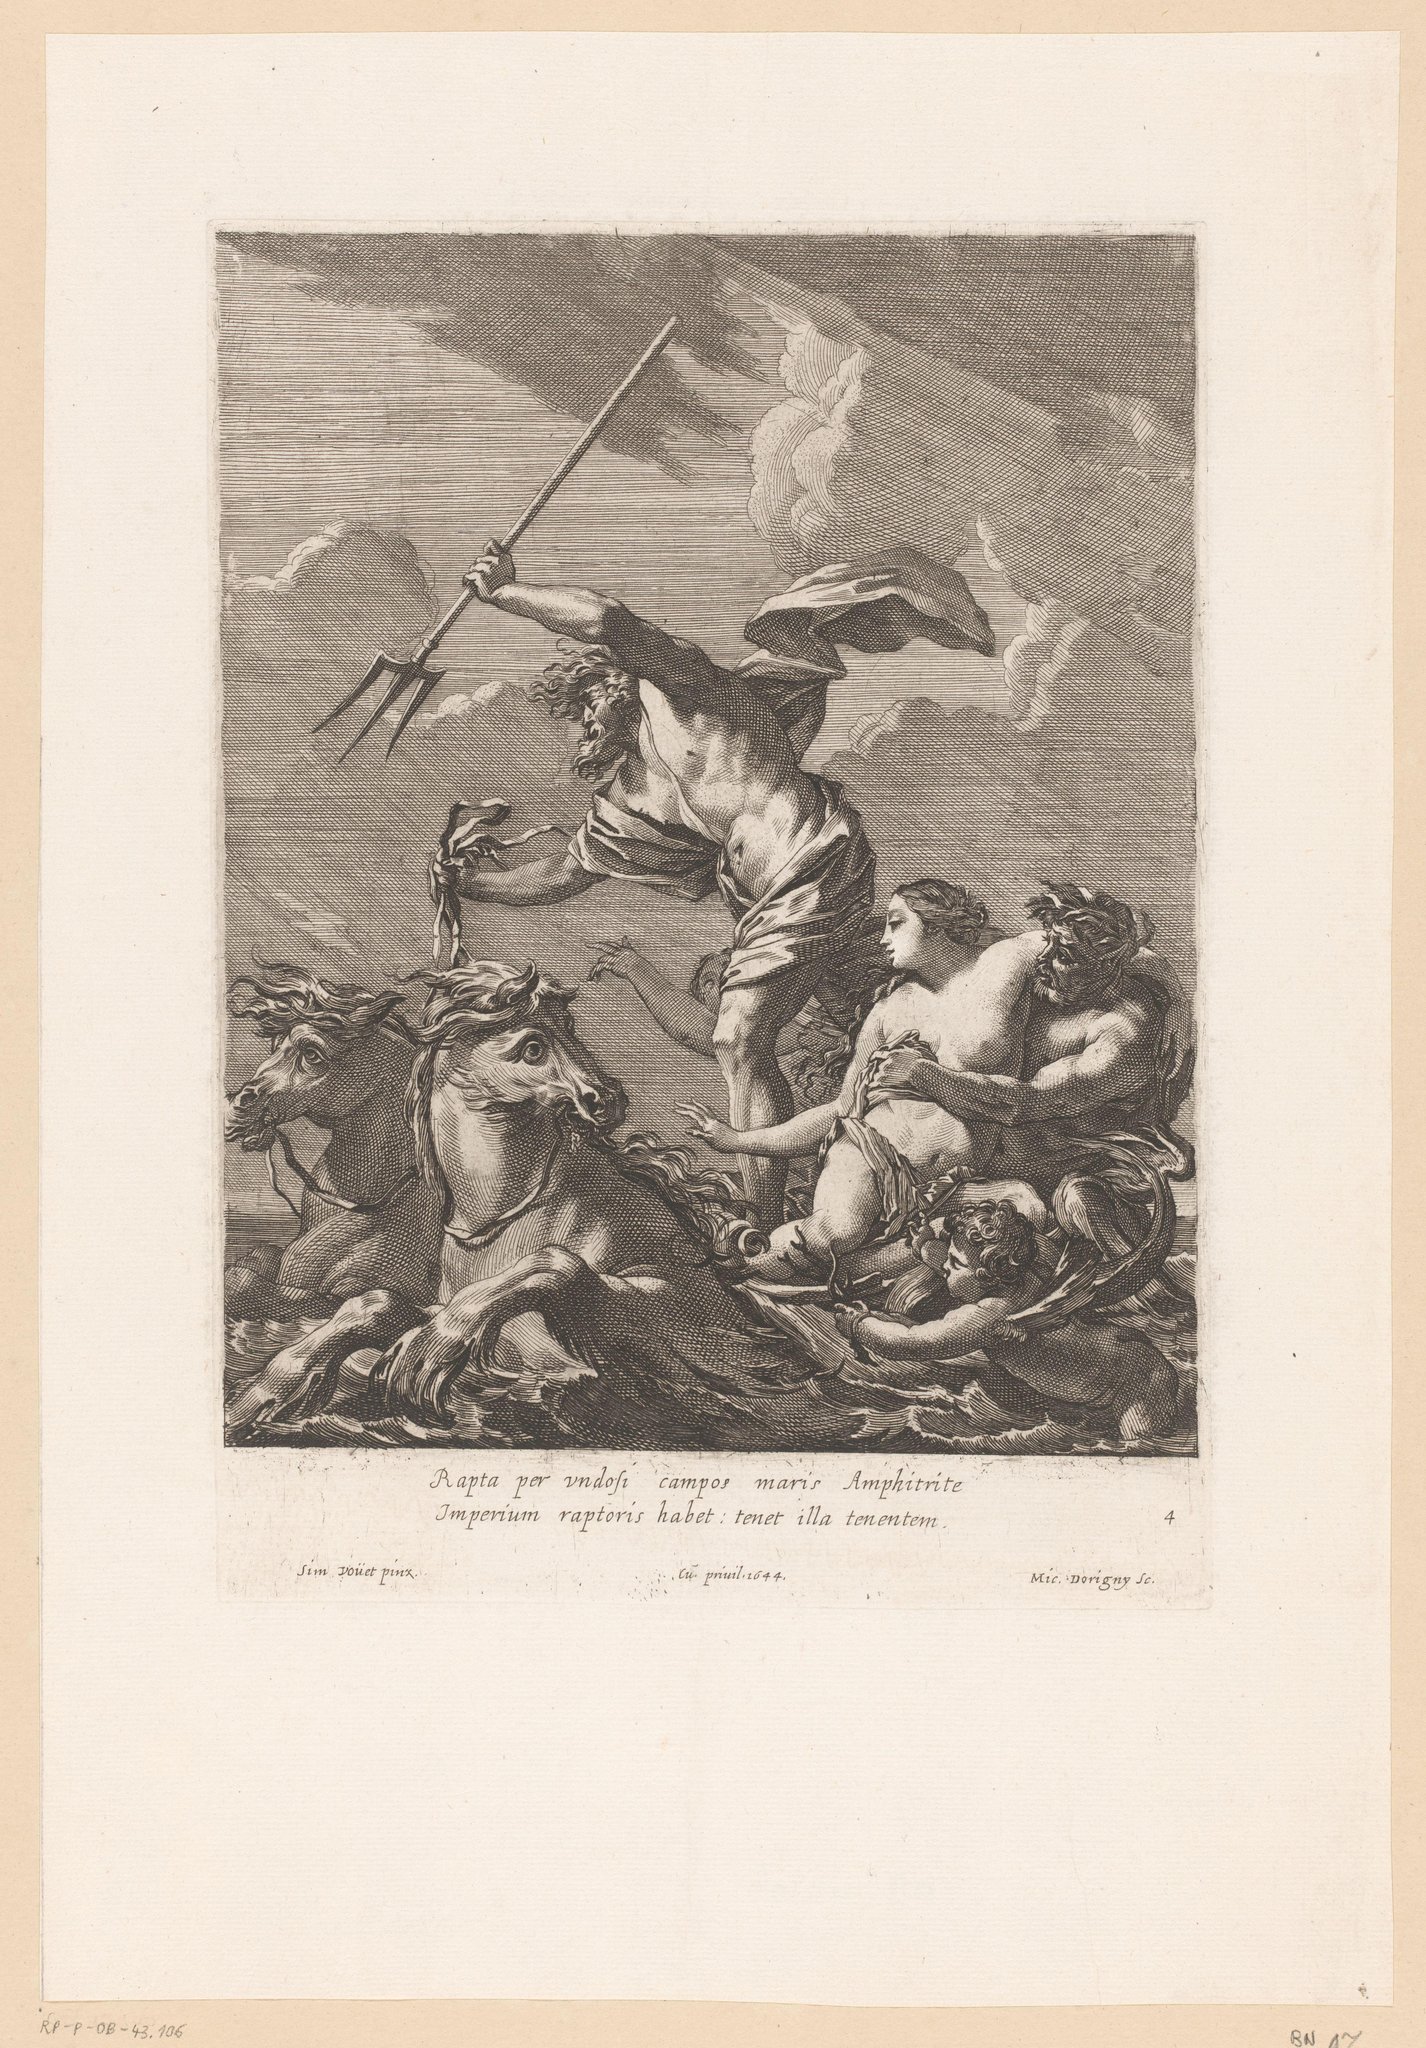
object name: print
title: Serie van prenten naar de schilderijen van Fontainebleau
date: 1644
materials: paper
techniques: engraving, etching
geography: france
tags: (story of) neptune (poseidon), triumph of amphitrite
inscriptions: collector's mark: Lugt 240